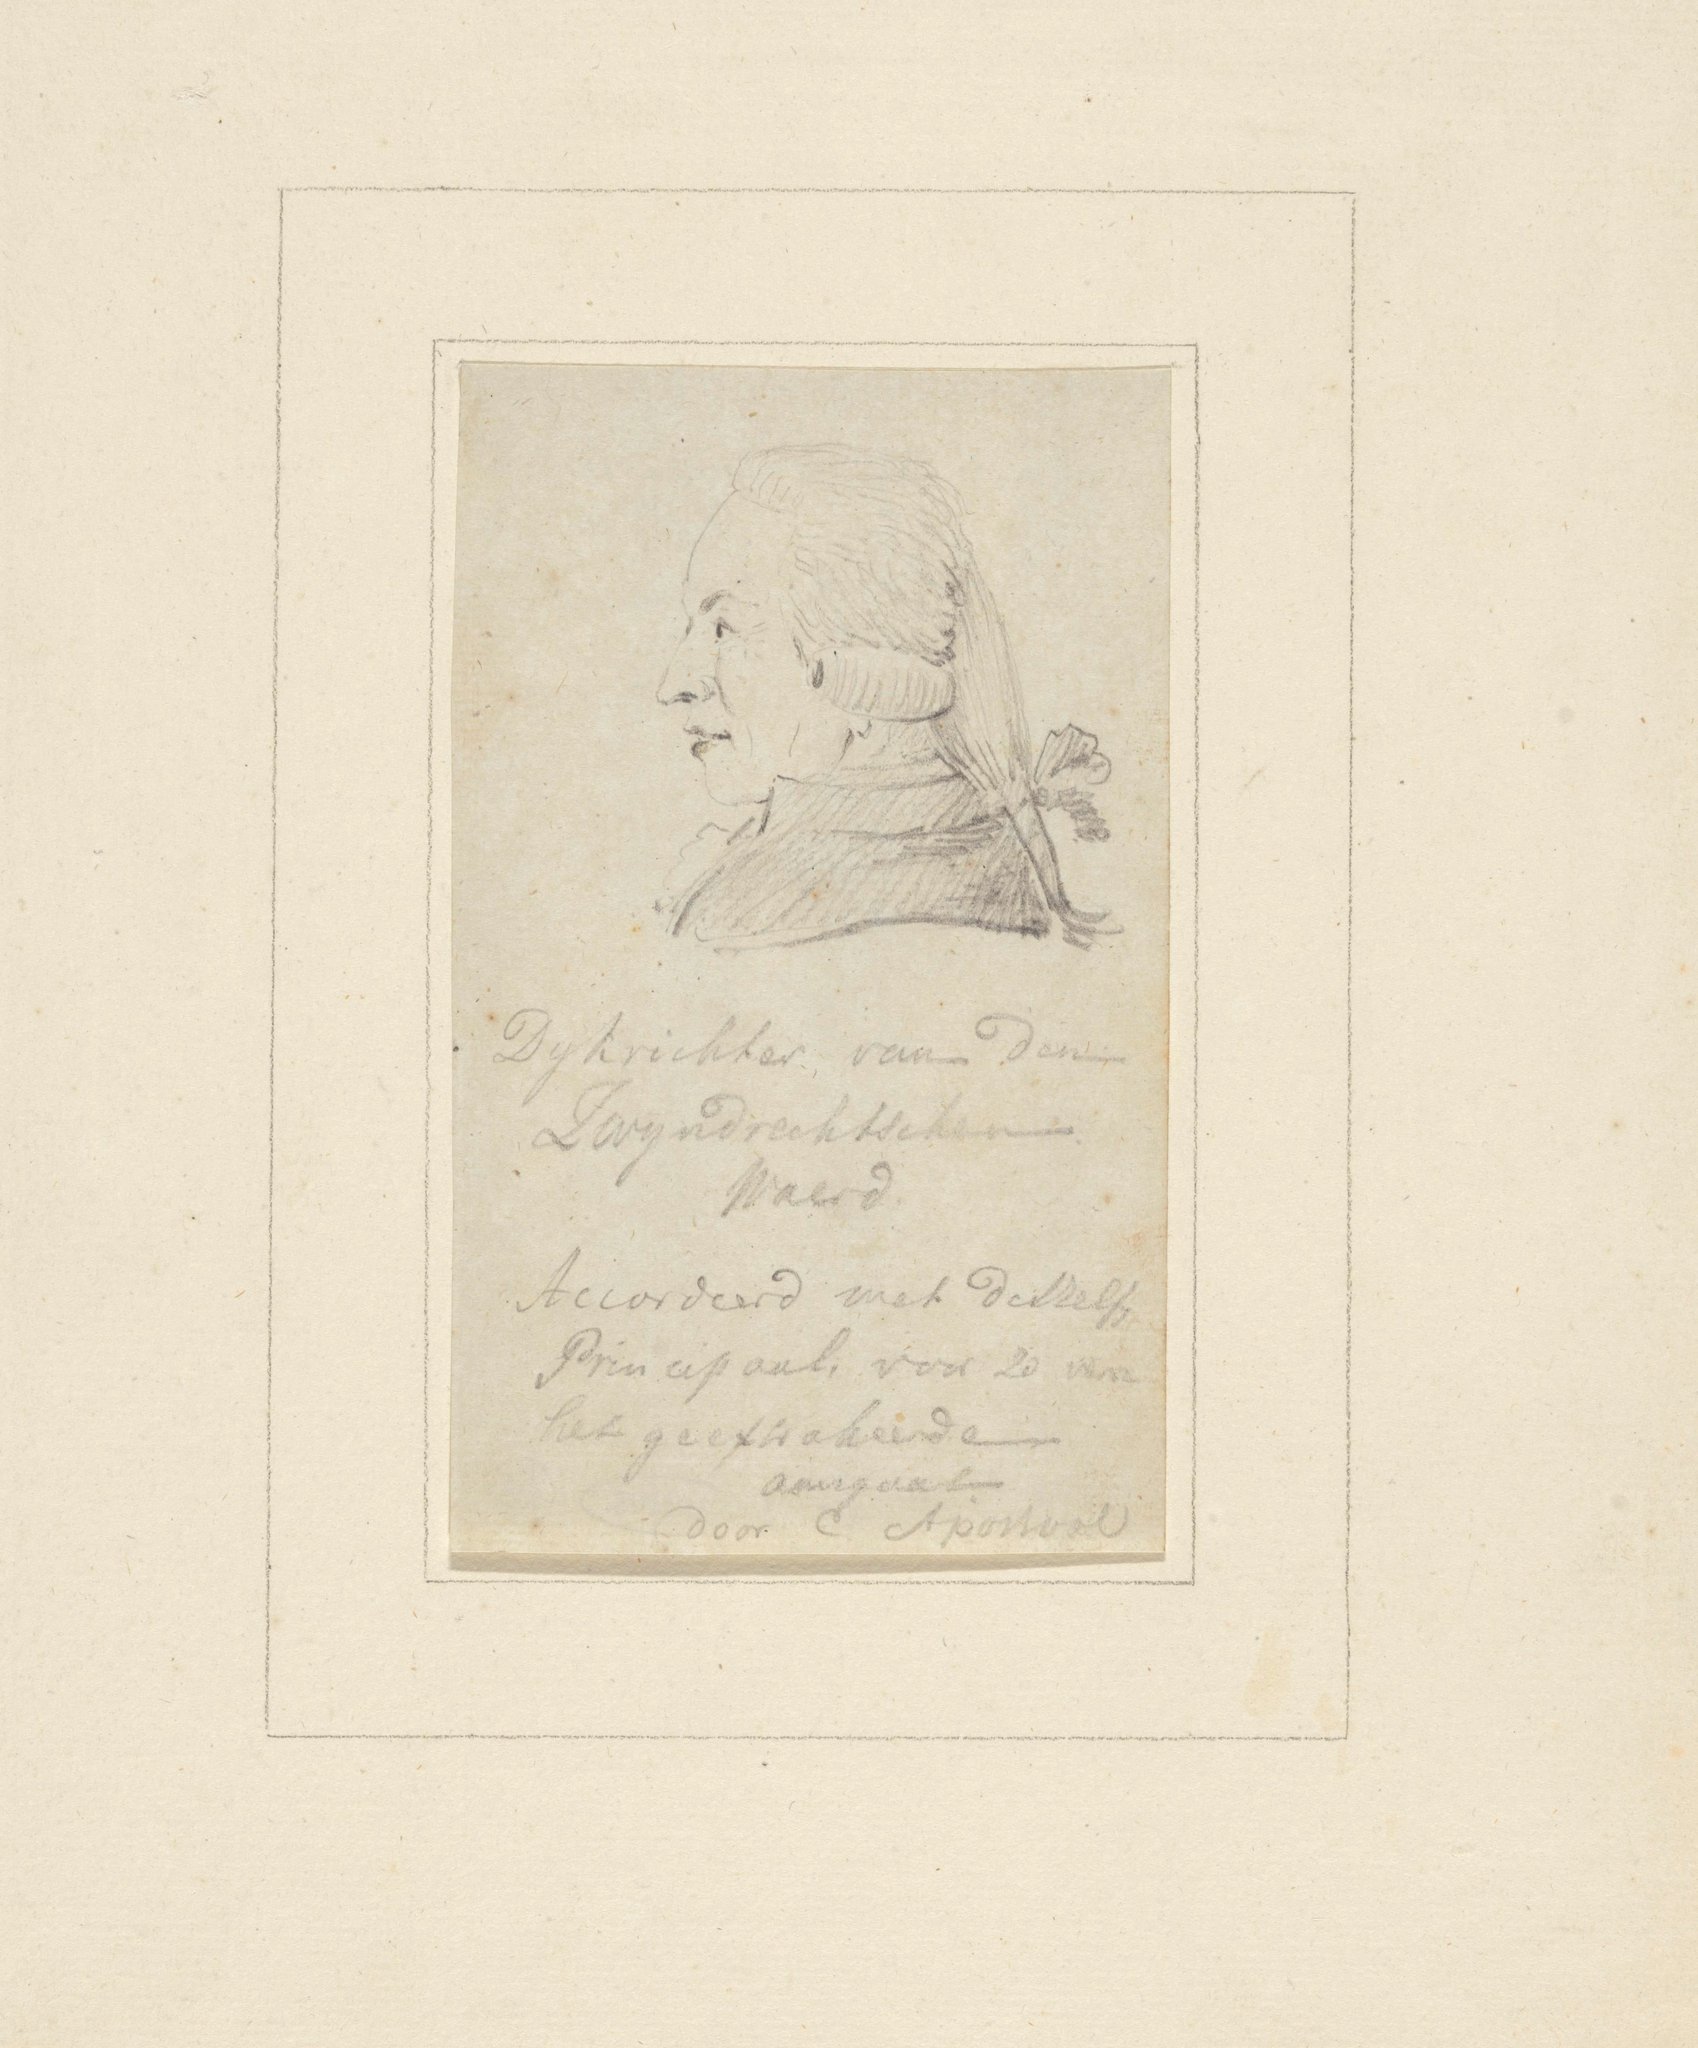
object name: drawing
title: Dijkrichter van de Zwyndrechtse waard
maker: cornelis apostool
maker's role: draughtsman, print maker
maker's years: 1762-1844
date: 1772-1844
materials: chalk, paper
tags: anonymous historical person portrayed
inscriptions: caption: ‘Dijkrichter van de Zwyndrechtse waard / Accordeerd met deszelfs Principaal voor zo (...) het geextra(...) aangaat / door C Apostool’